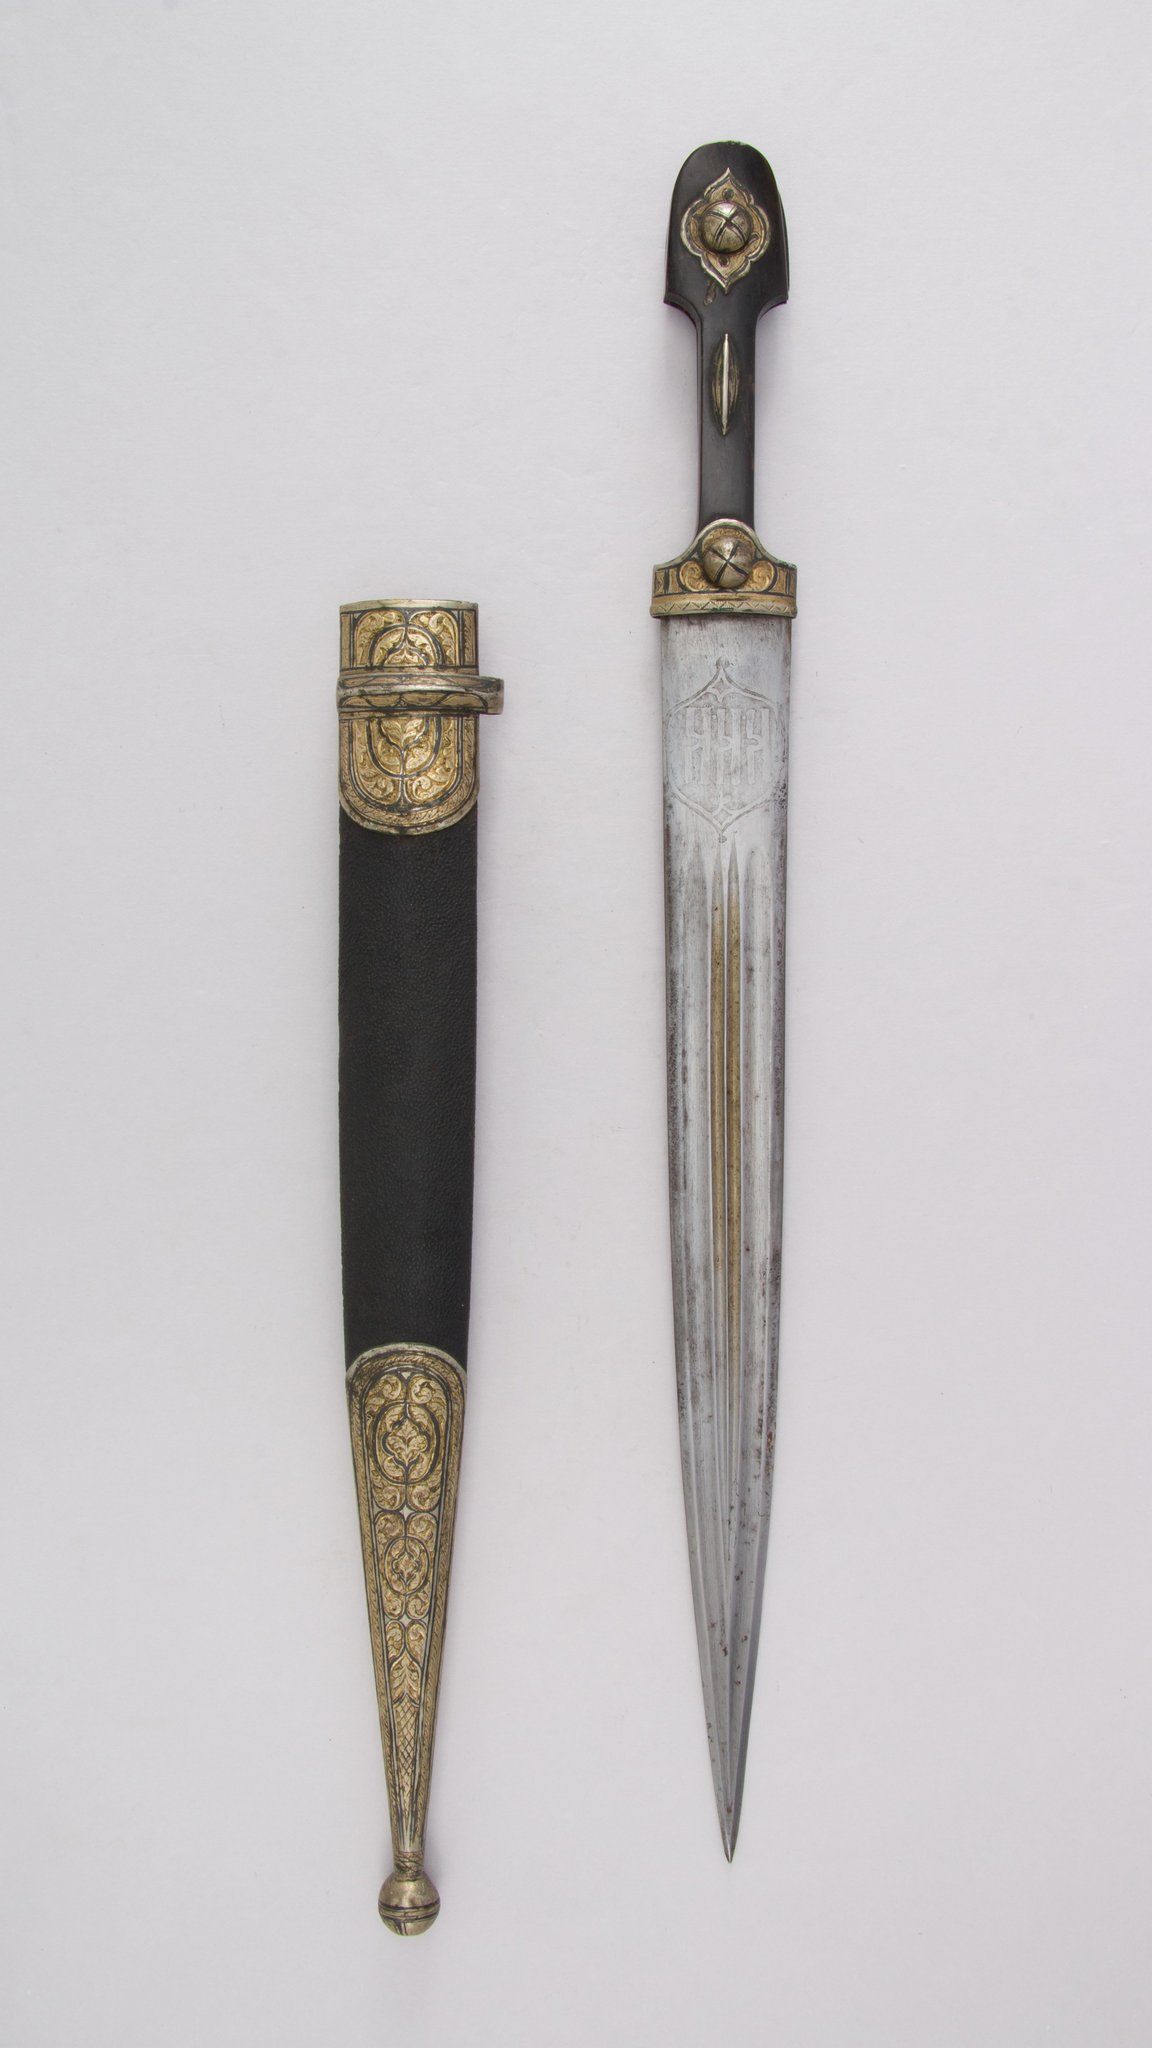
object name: dagger with sheath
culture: caucasian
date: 1701-1900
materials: horn, leather, silver, steel, wood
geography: caucasus